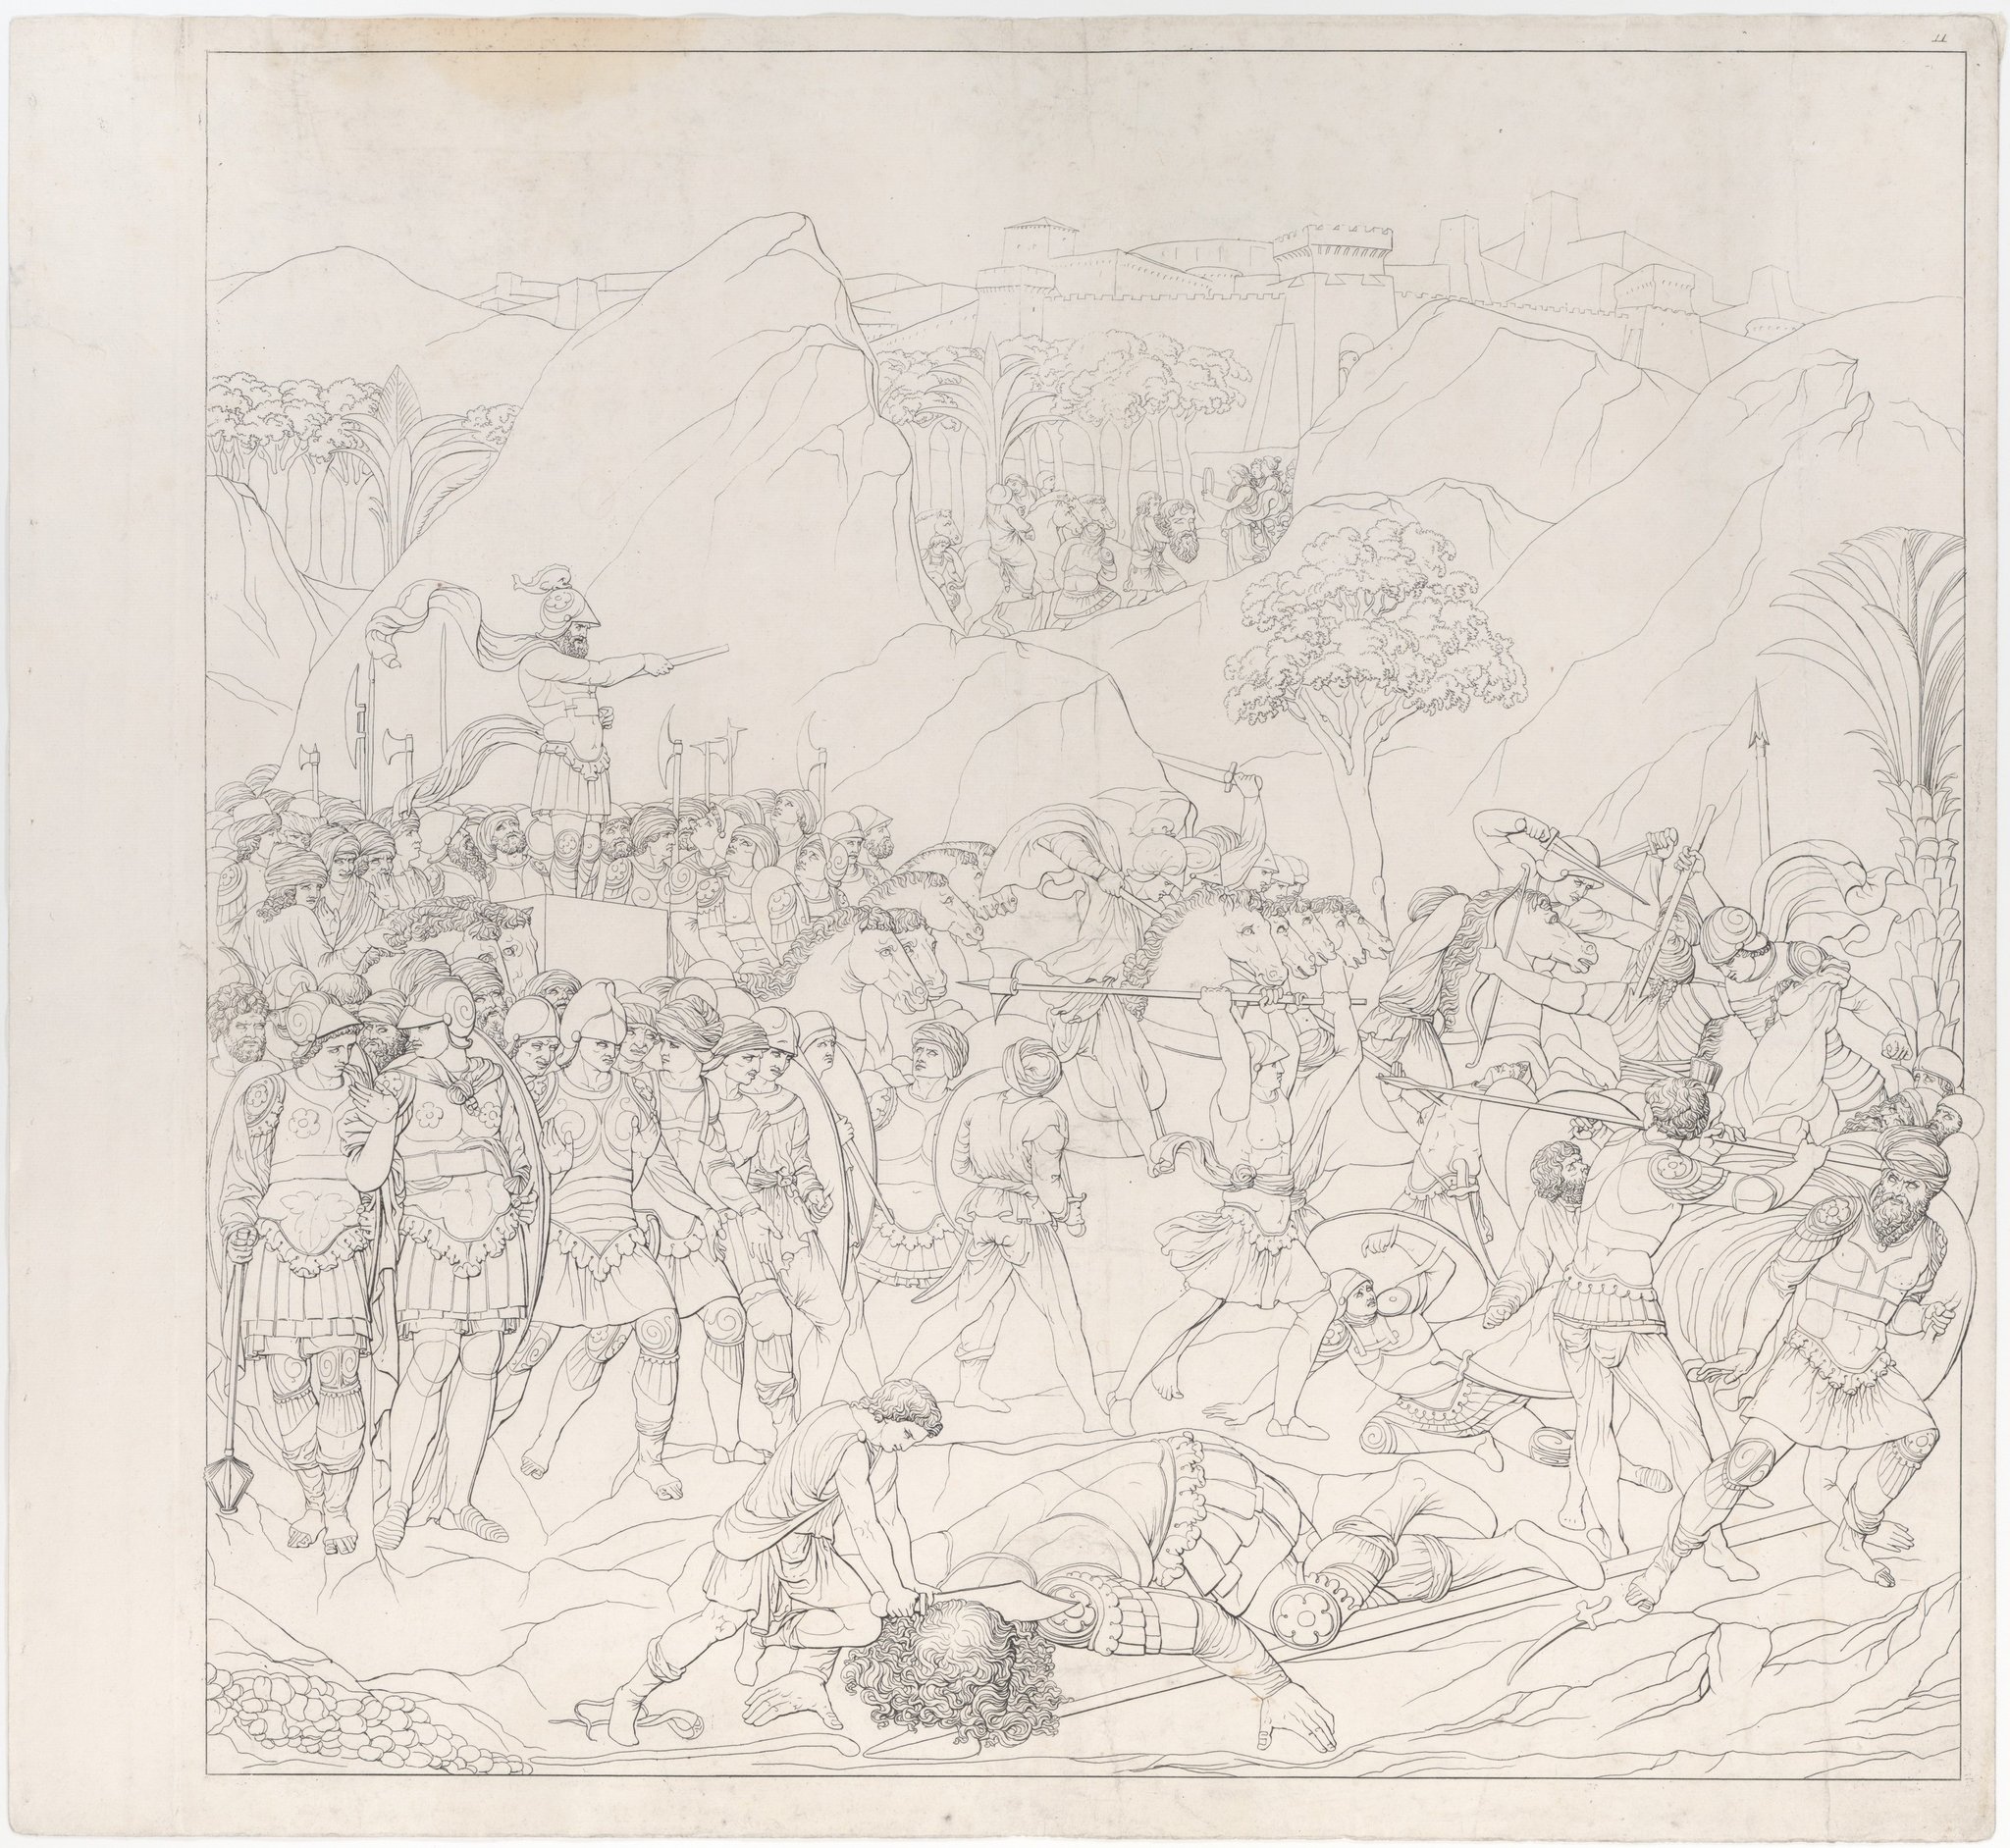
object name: print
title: Gates of Paradise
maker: feodor ivanovich kalmuk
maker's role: artist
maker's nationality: russian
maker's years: 1765-1832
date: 1798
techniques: engraving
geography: italy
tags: battles,soldiers,spears,swords,horses